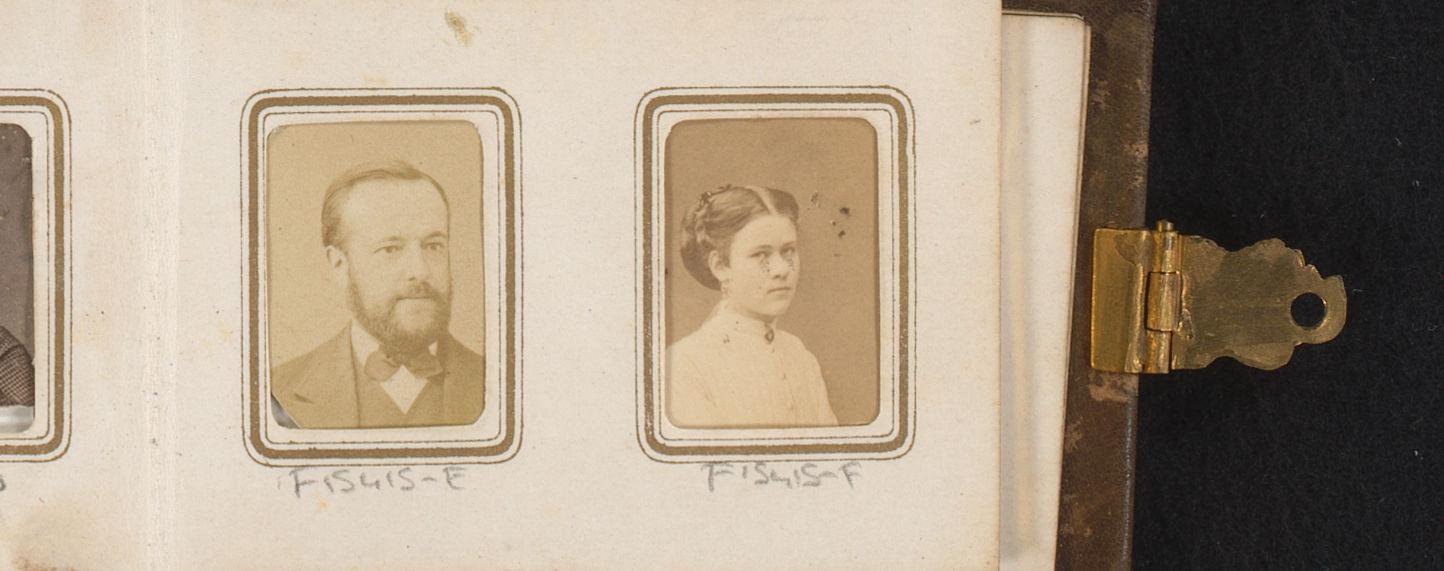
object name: photograph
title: Miniatuurportet van een onbekende jonge vrouw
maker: Anonymous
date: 1851-1870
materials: paper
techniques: albumen print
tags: anonymous historical person portrayed - bb - woman